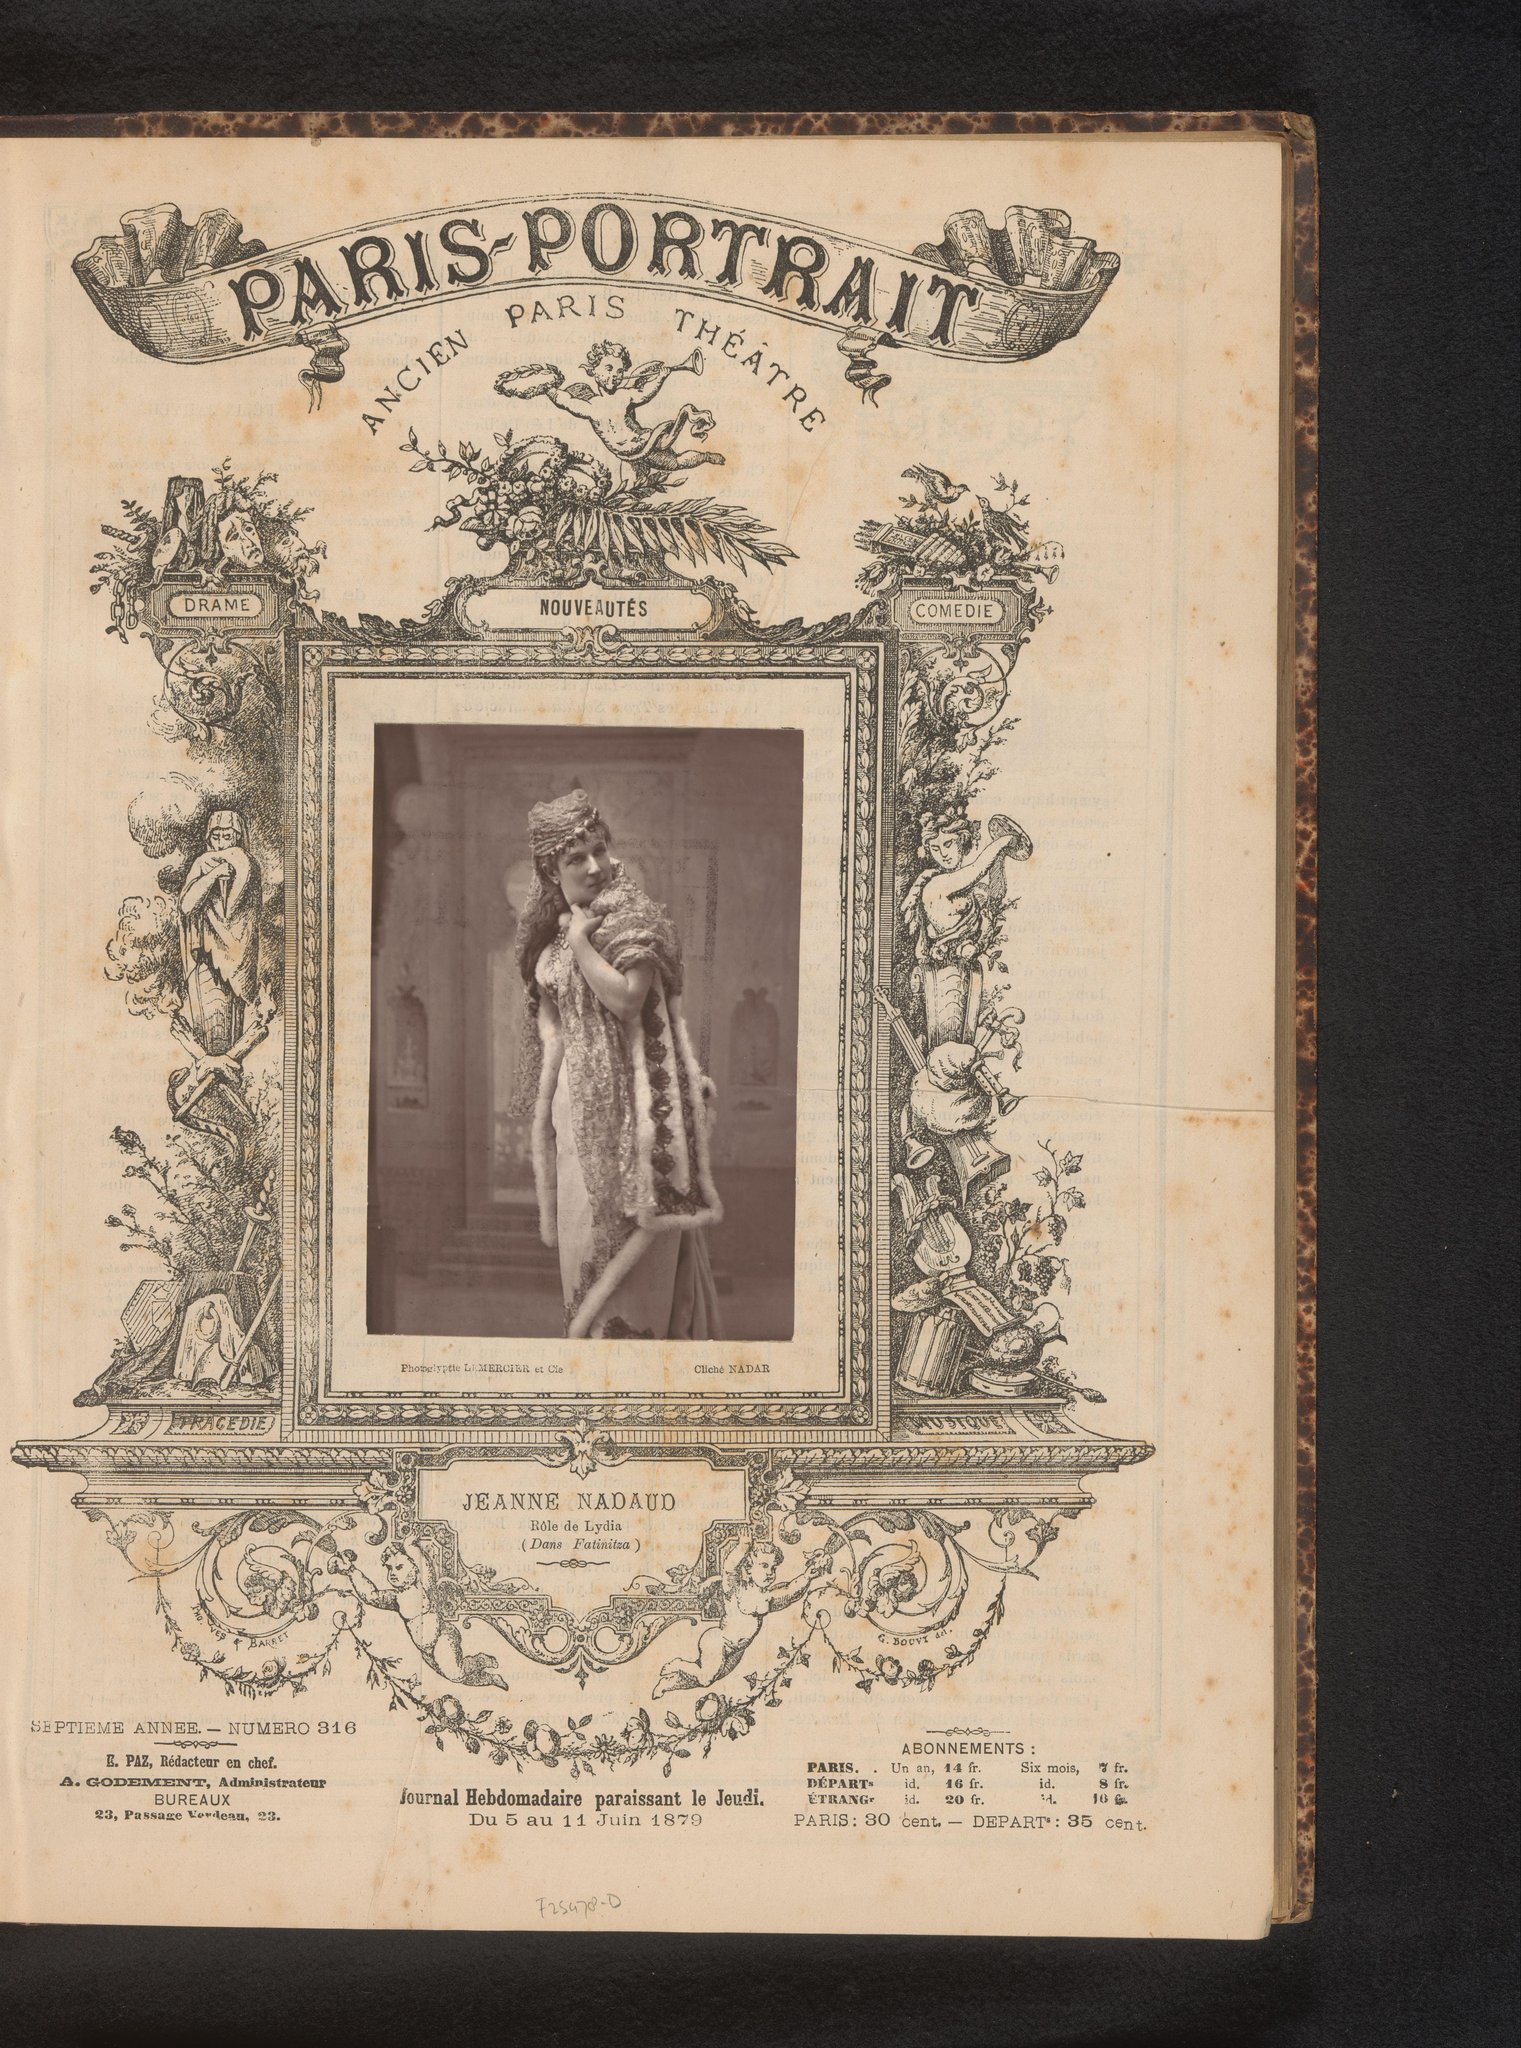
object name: photomechanical print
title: Portret van Jeanne Nadaud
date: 1873-1880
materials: paper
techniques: woodburytype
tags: historical persons - bb - woman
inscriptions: inscription: ‘Role de Lydia (Dans Fatinitza)’